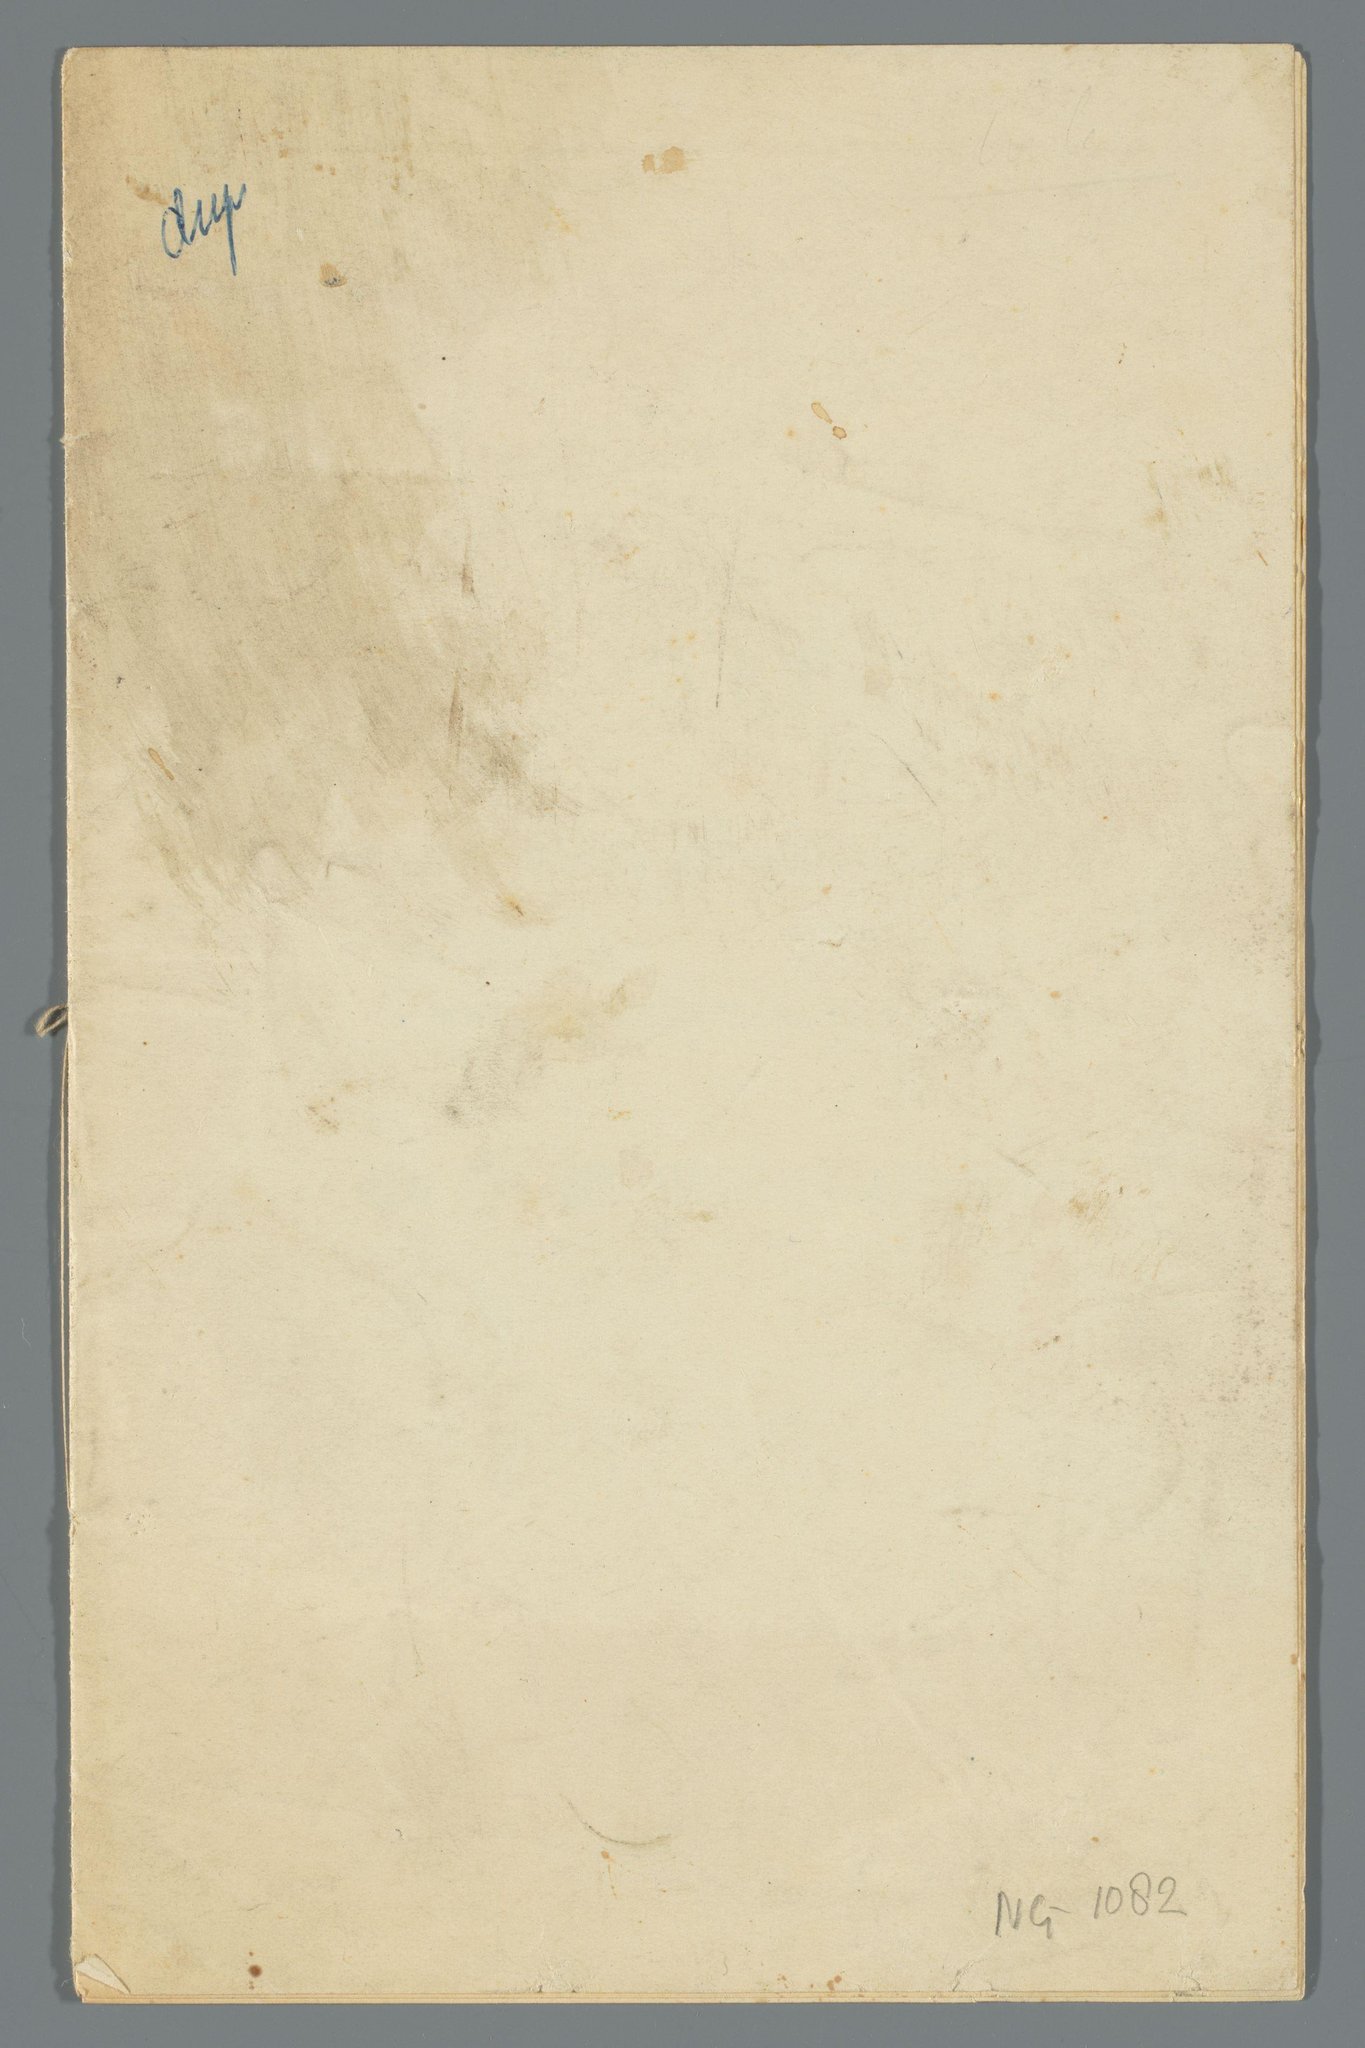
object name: brochure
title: Wet van den 29sten september 1815, No. 49 Houdende instelling van de Orde van de Nederlandse Leeuw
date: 1849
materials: paper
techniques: printing, sewing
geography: netherlands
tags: netherlands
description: Twee pagina's dubbel bedrukte tekst (de wet op de instelling van de orde van de Nederlandse Leeuw) met titelpagina genaaid in blanco kaftje.